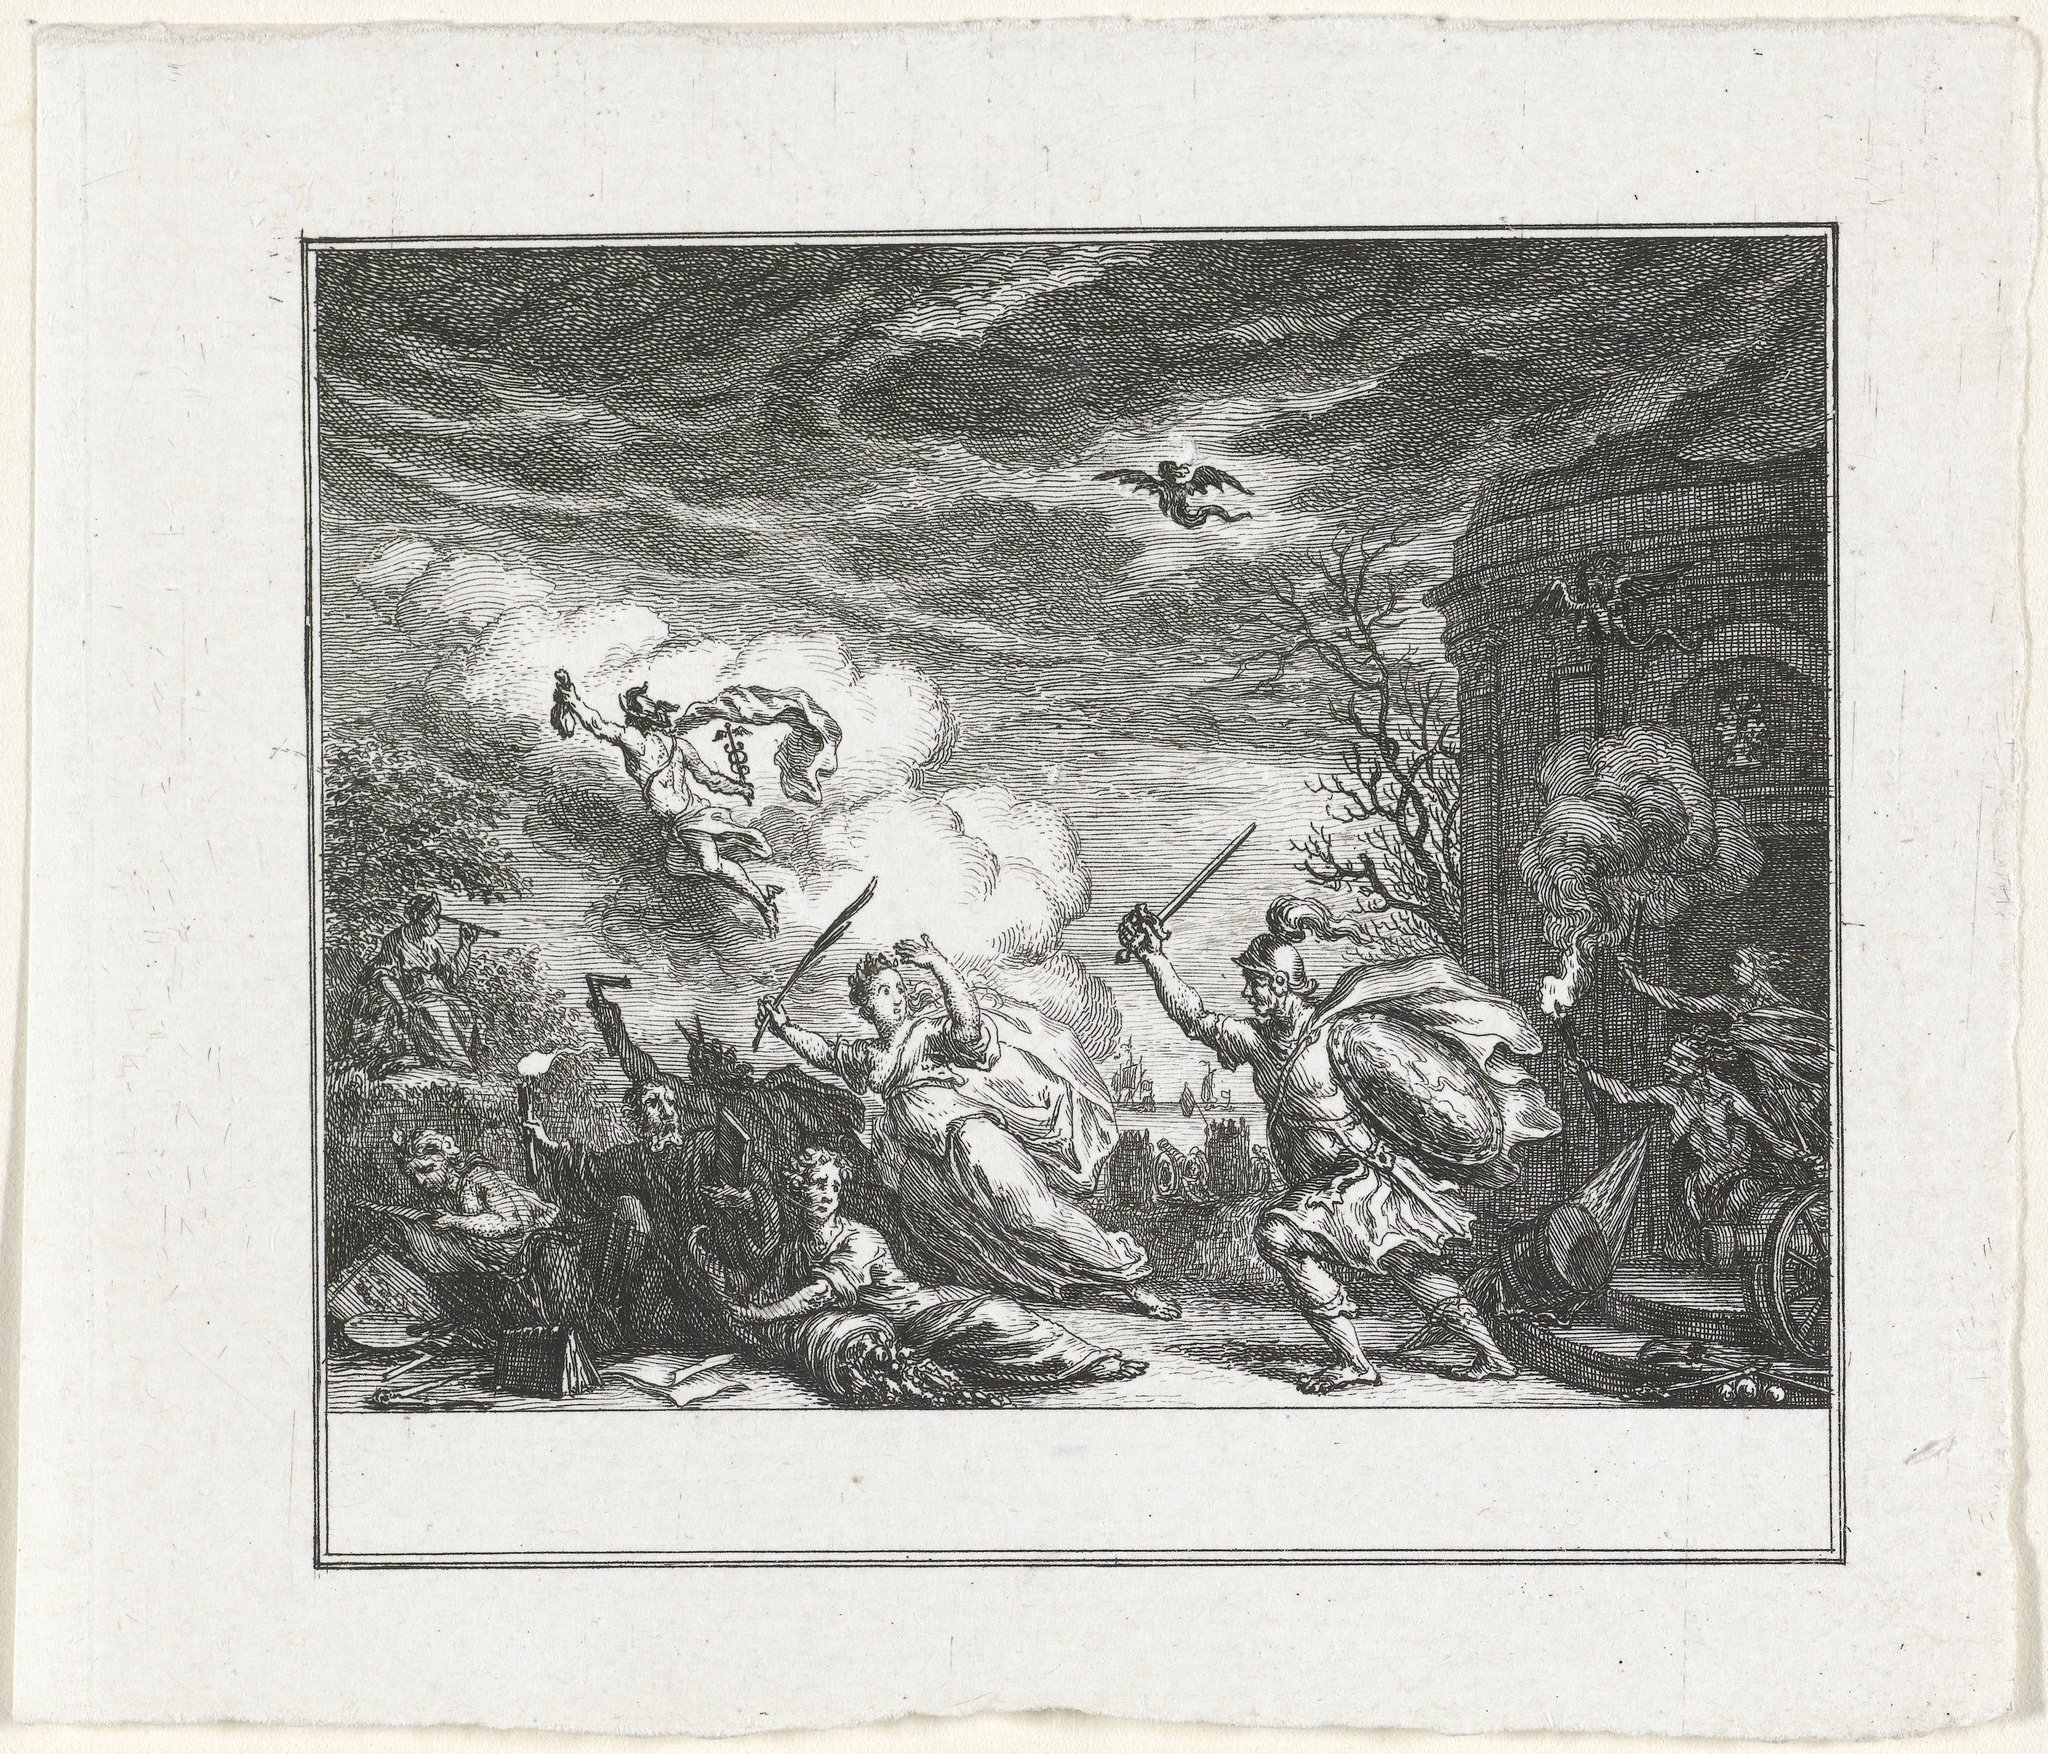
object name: print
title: Vrede door Oorlog verjaagd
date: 1780-1782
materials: paper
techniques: etching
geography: amsterdam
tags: symbols, allegories of peace, 'pax'; 'pace' (ripa), devil(s) and demons, symbols, allegories of war; 'guerra' (ripa), attributes of mercury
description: De personificatie van de Vrede slaat met haar palmtak op de vlucht wanneer de Oorlog haar, met hulp van duivelse figuren, met schild en zwaard achtervolgt. In de lucht vliegt Mercurius weg.